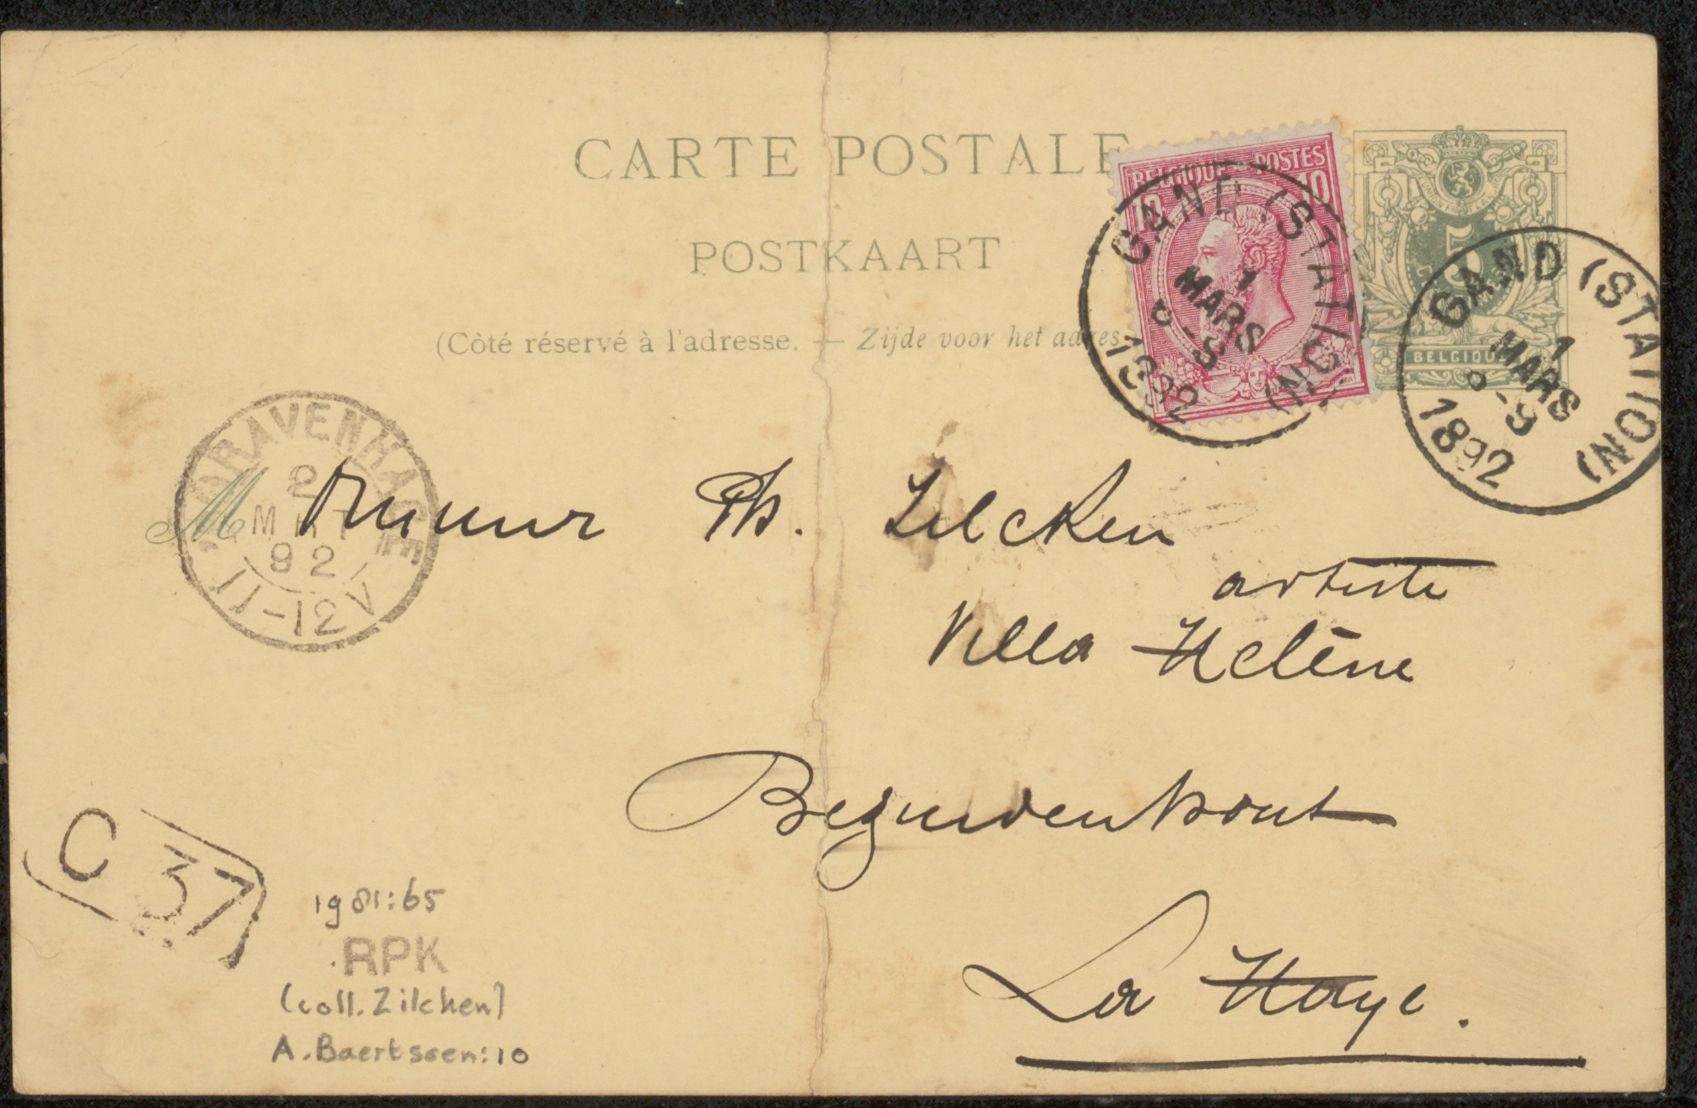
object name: postcard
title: Briefkaart aan Philip Zilcken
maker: albert baertsoen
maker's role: draughtsman, print maker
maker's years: 1866-1922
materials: cardboard, ink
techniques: pen, writing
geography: ghent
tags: the hague, painter, philip zilcken, temporary exhibition, 'salon', ghent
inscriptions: collector's mark: ‘RPK’